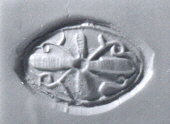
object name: stamp seal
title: Cowroid seal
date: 1700-1520 BCE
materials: stone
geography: egypt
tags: flowers